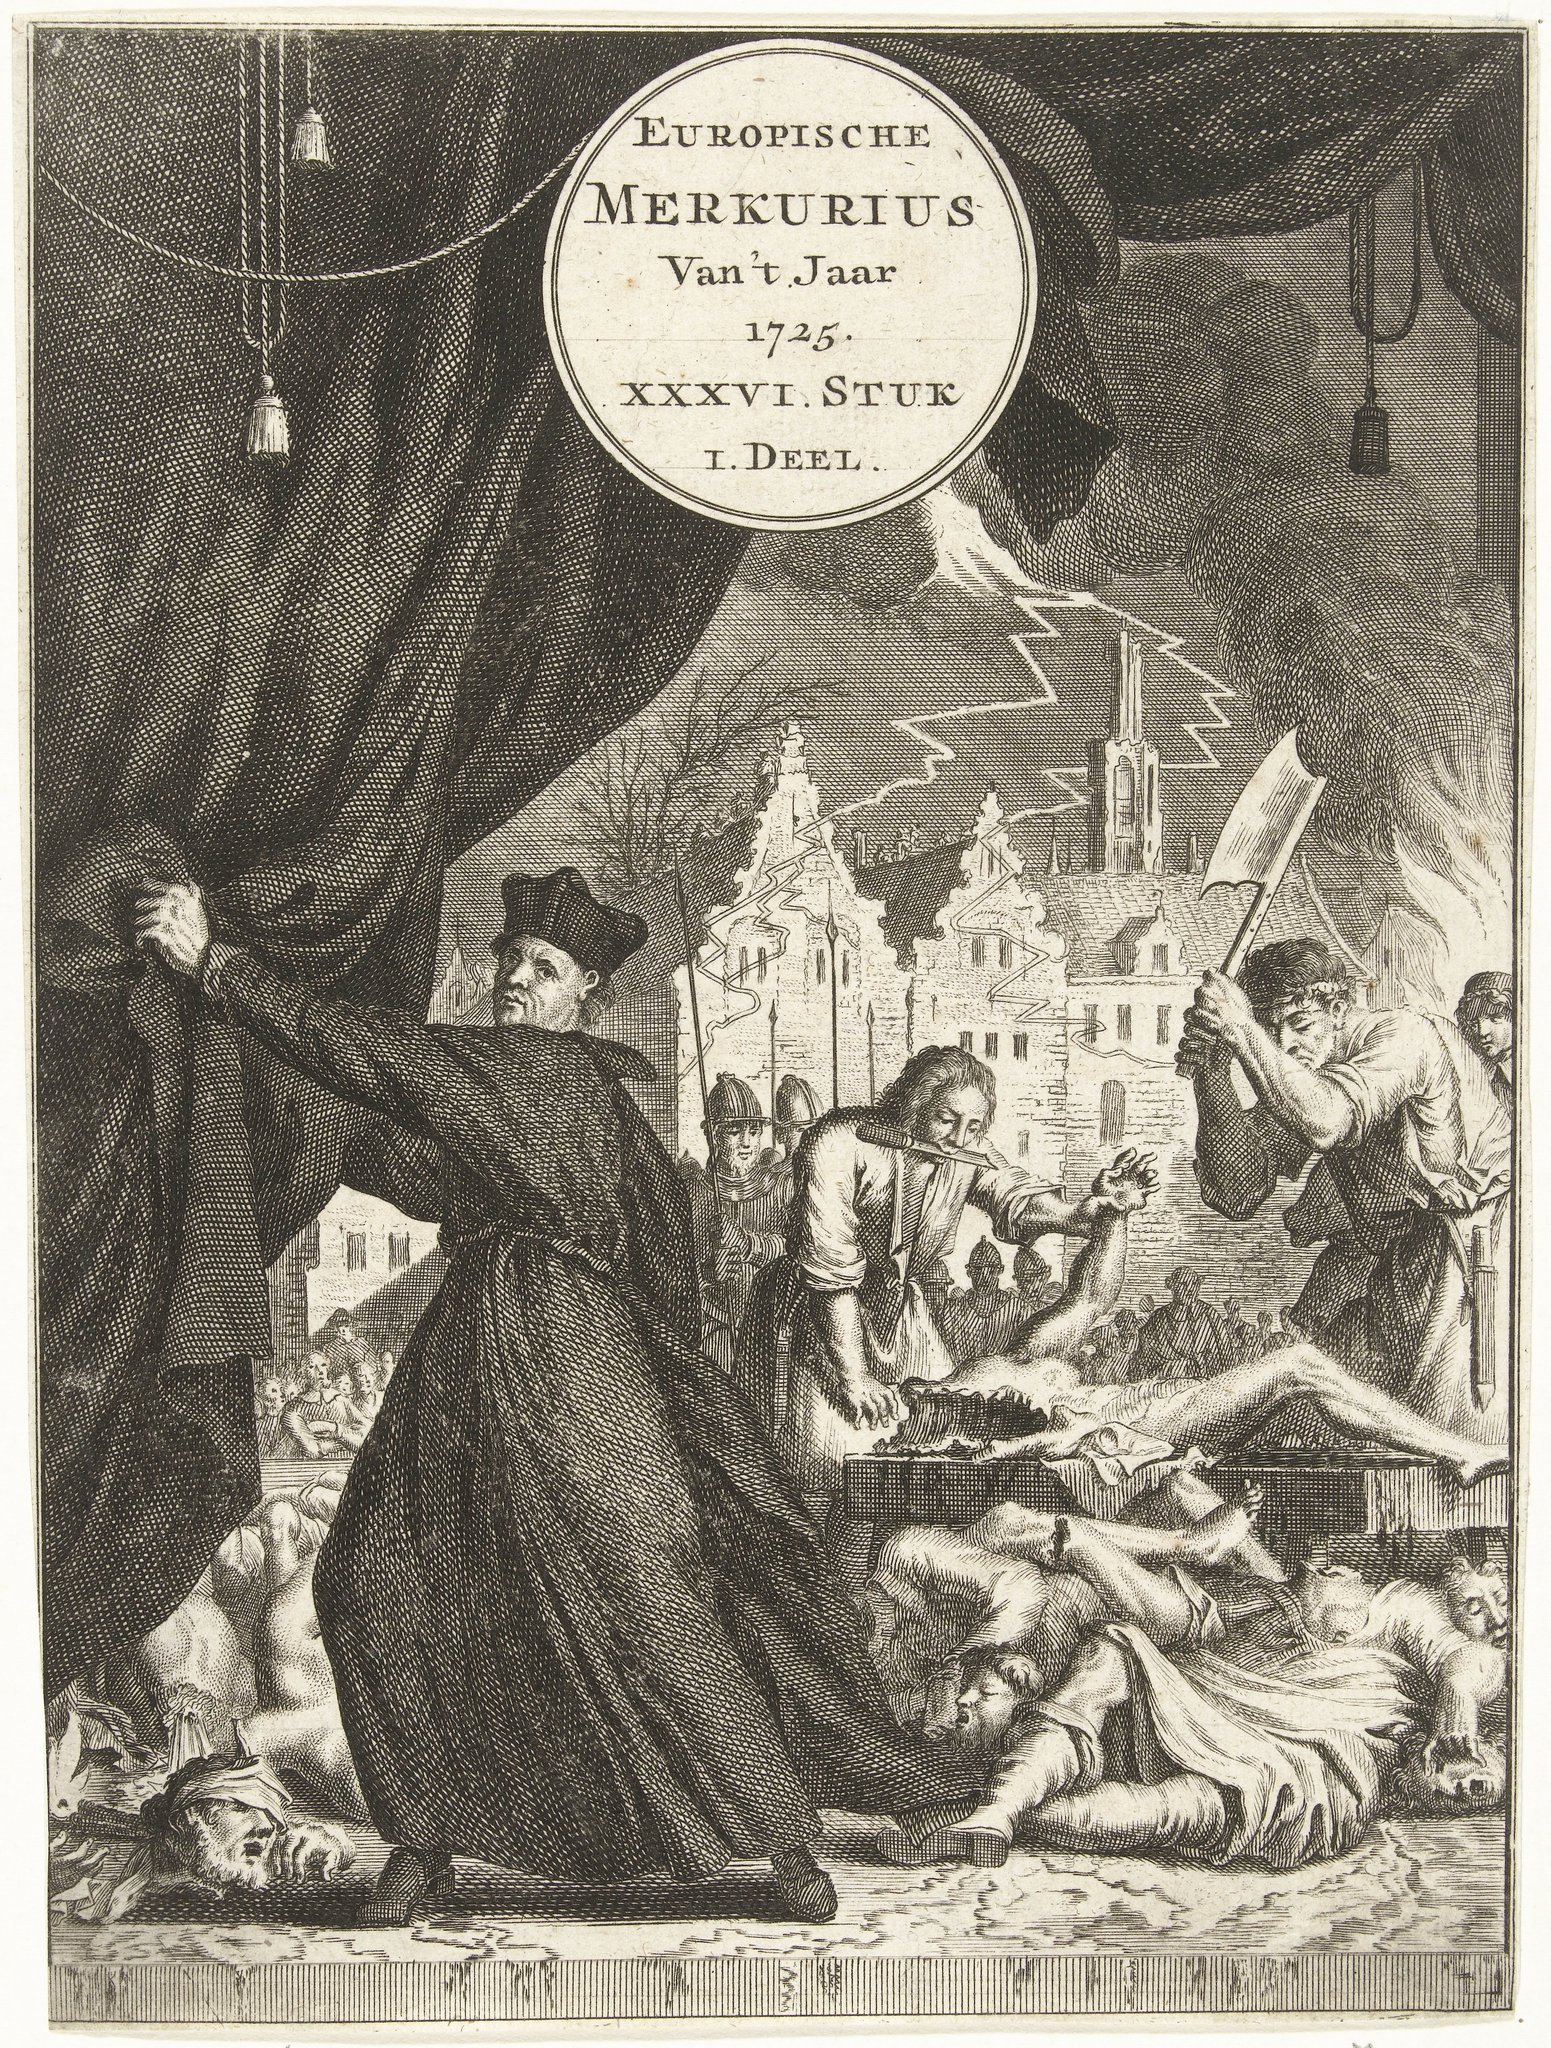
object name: titelblad, titelpagina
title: Titelpagina voor de Europische Mercurius van 1725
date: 1725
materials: paper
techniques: engraving, etching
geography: amsterdam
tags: on the scaffold or place of execution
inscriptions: collector's mark: Lugt 2228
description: Titelpagina voor de Europische Mercurius, dl. XXXVI over het jaar 1725. Een geestelijke trekt een gordijn opzij en onthult een schavot waarop de lichamen van veroordeelden in stukken worden gehakt.